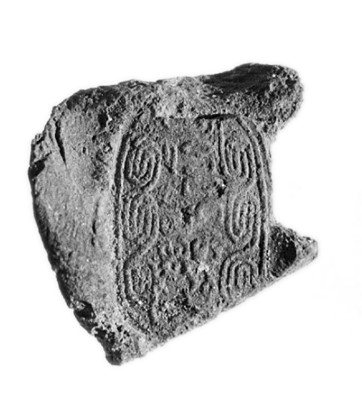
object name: sealing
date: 1981-1640 BCE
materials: mud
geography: egypt